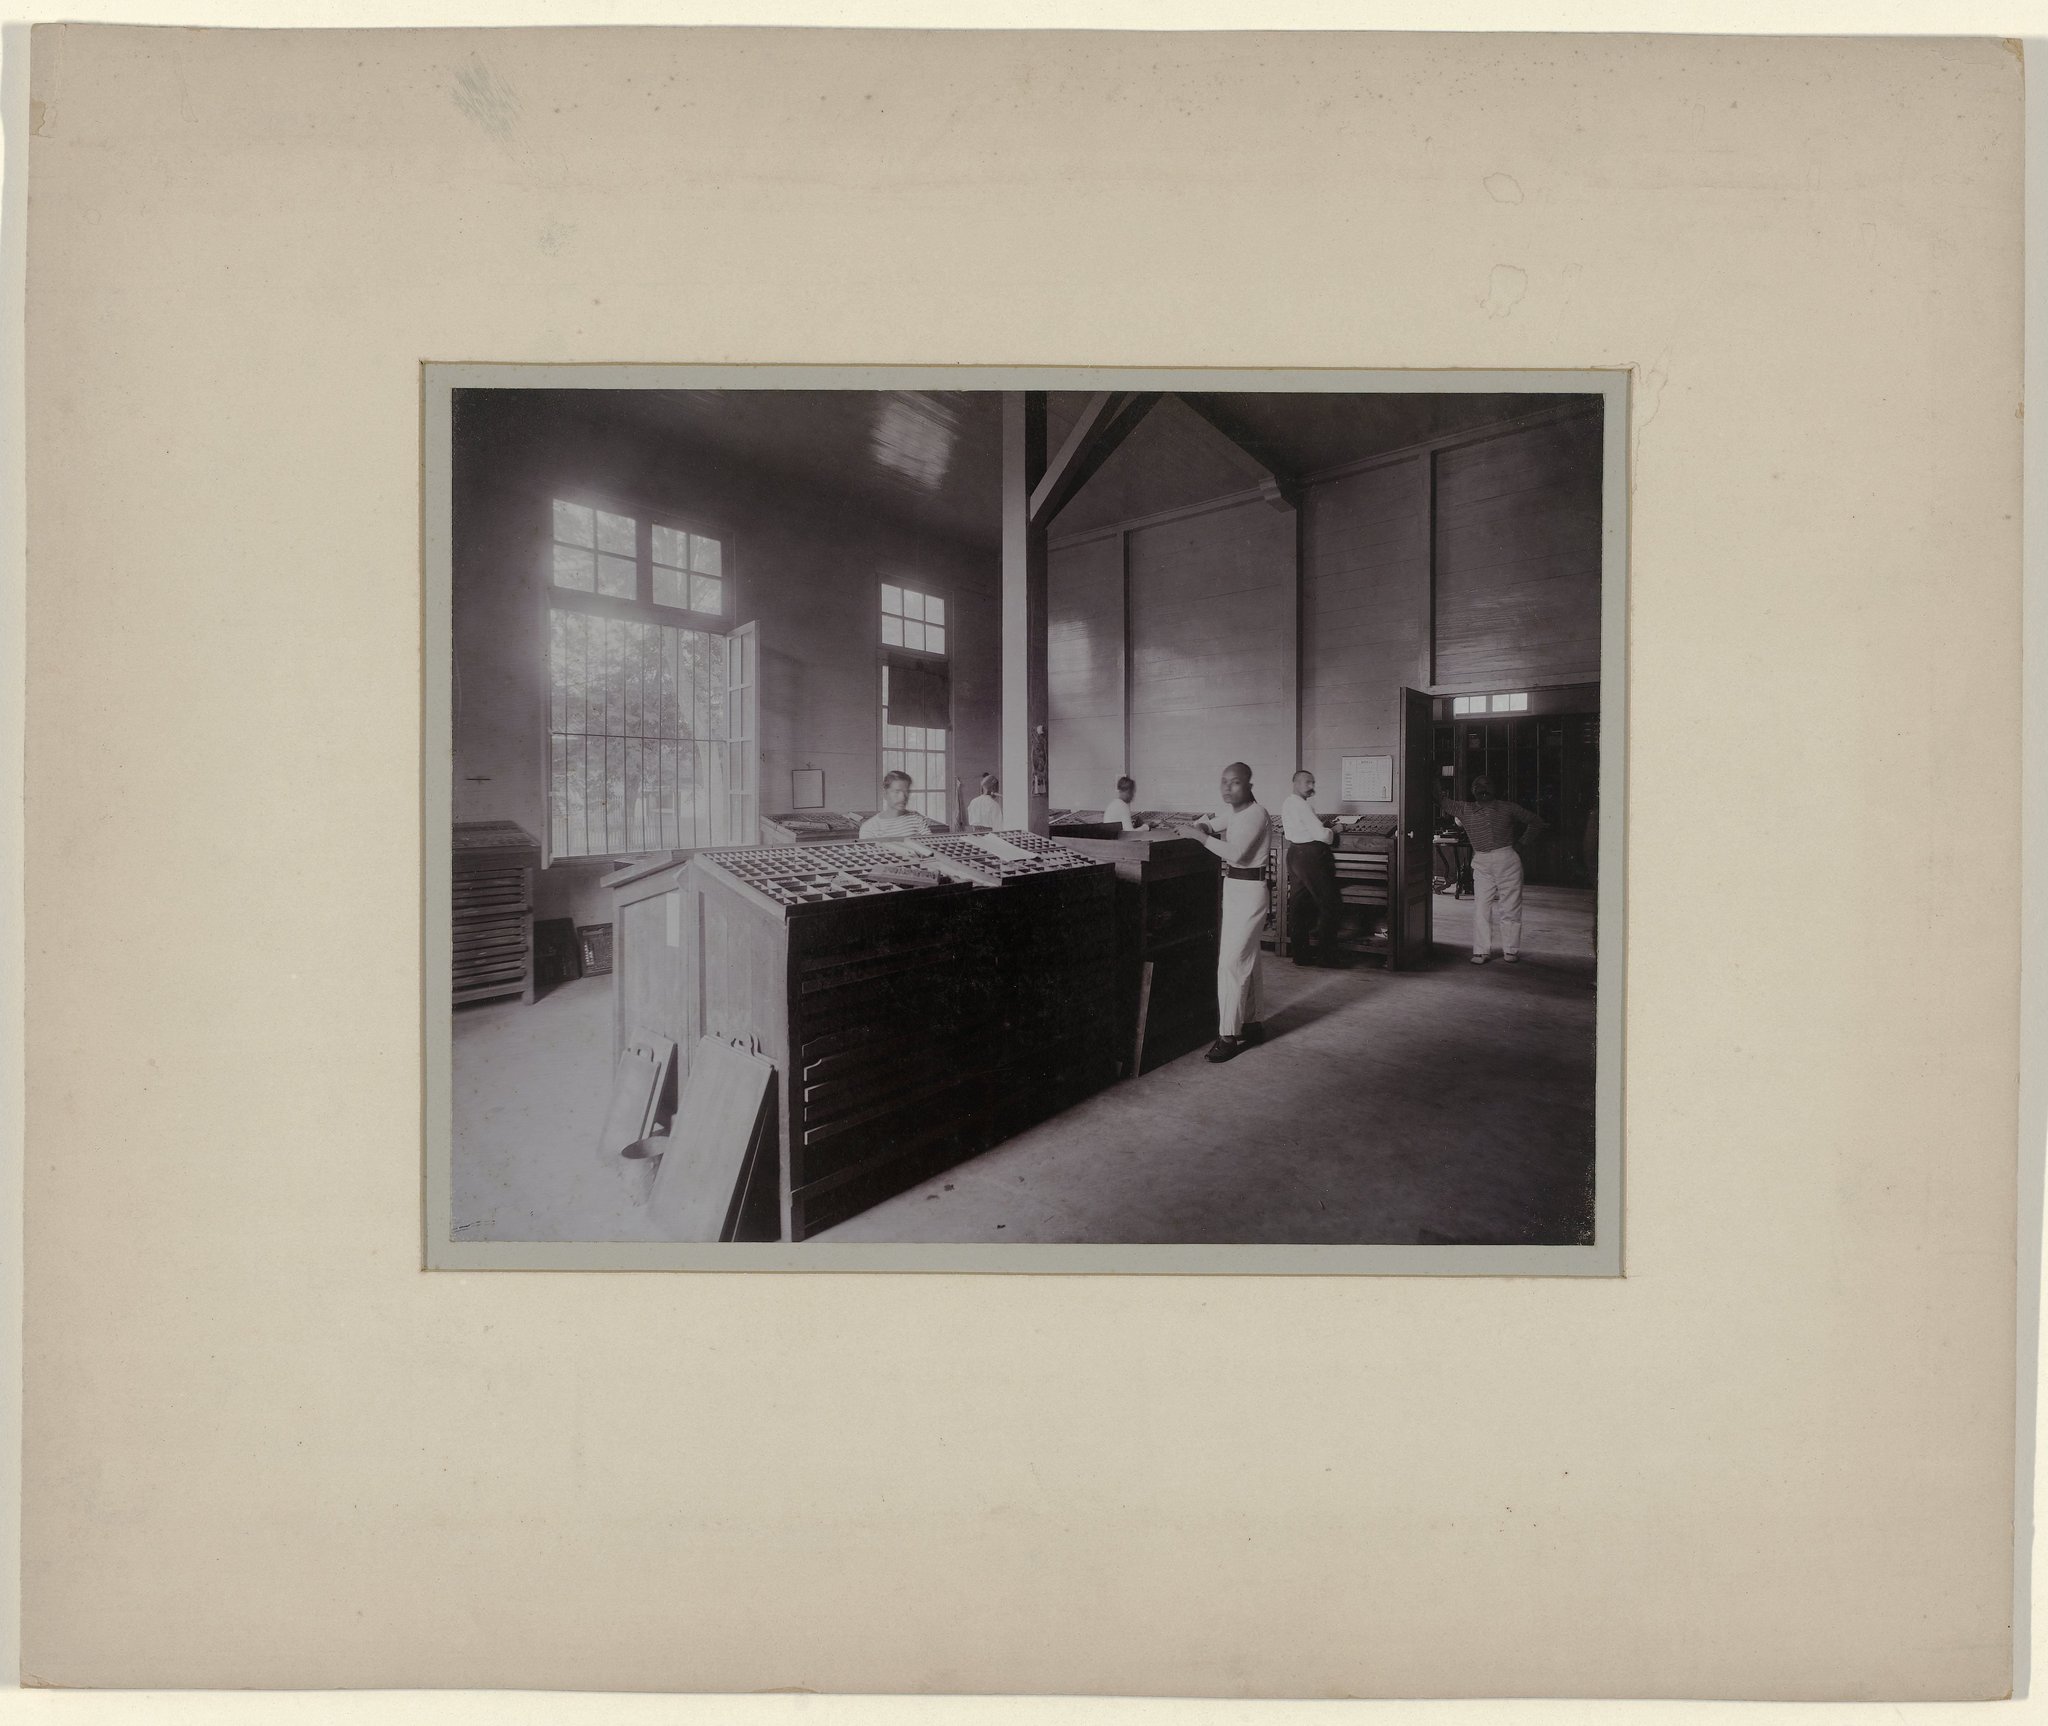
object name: photograph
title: Zetterij van de Deli Courant te Medan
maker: Anonymous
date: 1903-1908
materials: cardboard, photographic support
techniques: collodion silver print, gelatin silver print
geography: medan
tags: dutch east indies, the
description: Gezicht in de zetterij van de Deli Courant te Medan. Aan de werktafels staan Javaanse werknemers, aan de muur een kalender van augustus 1903. Onderdeel van een groep van 49 losse zwart-wit foto's van verschillend formaat over de uitgeverij en drukkerij van de krant Deli Courant in Medan in de periode 1885-1947.